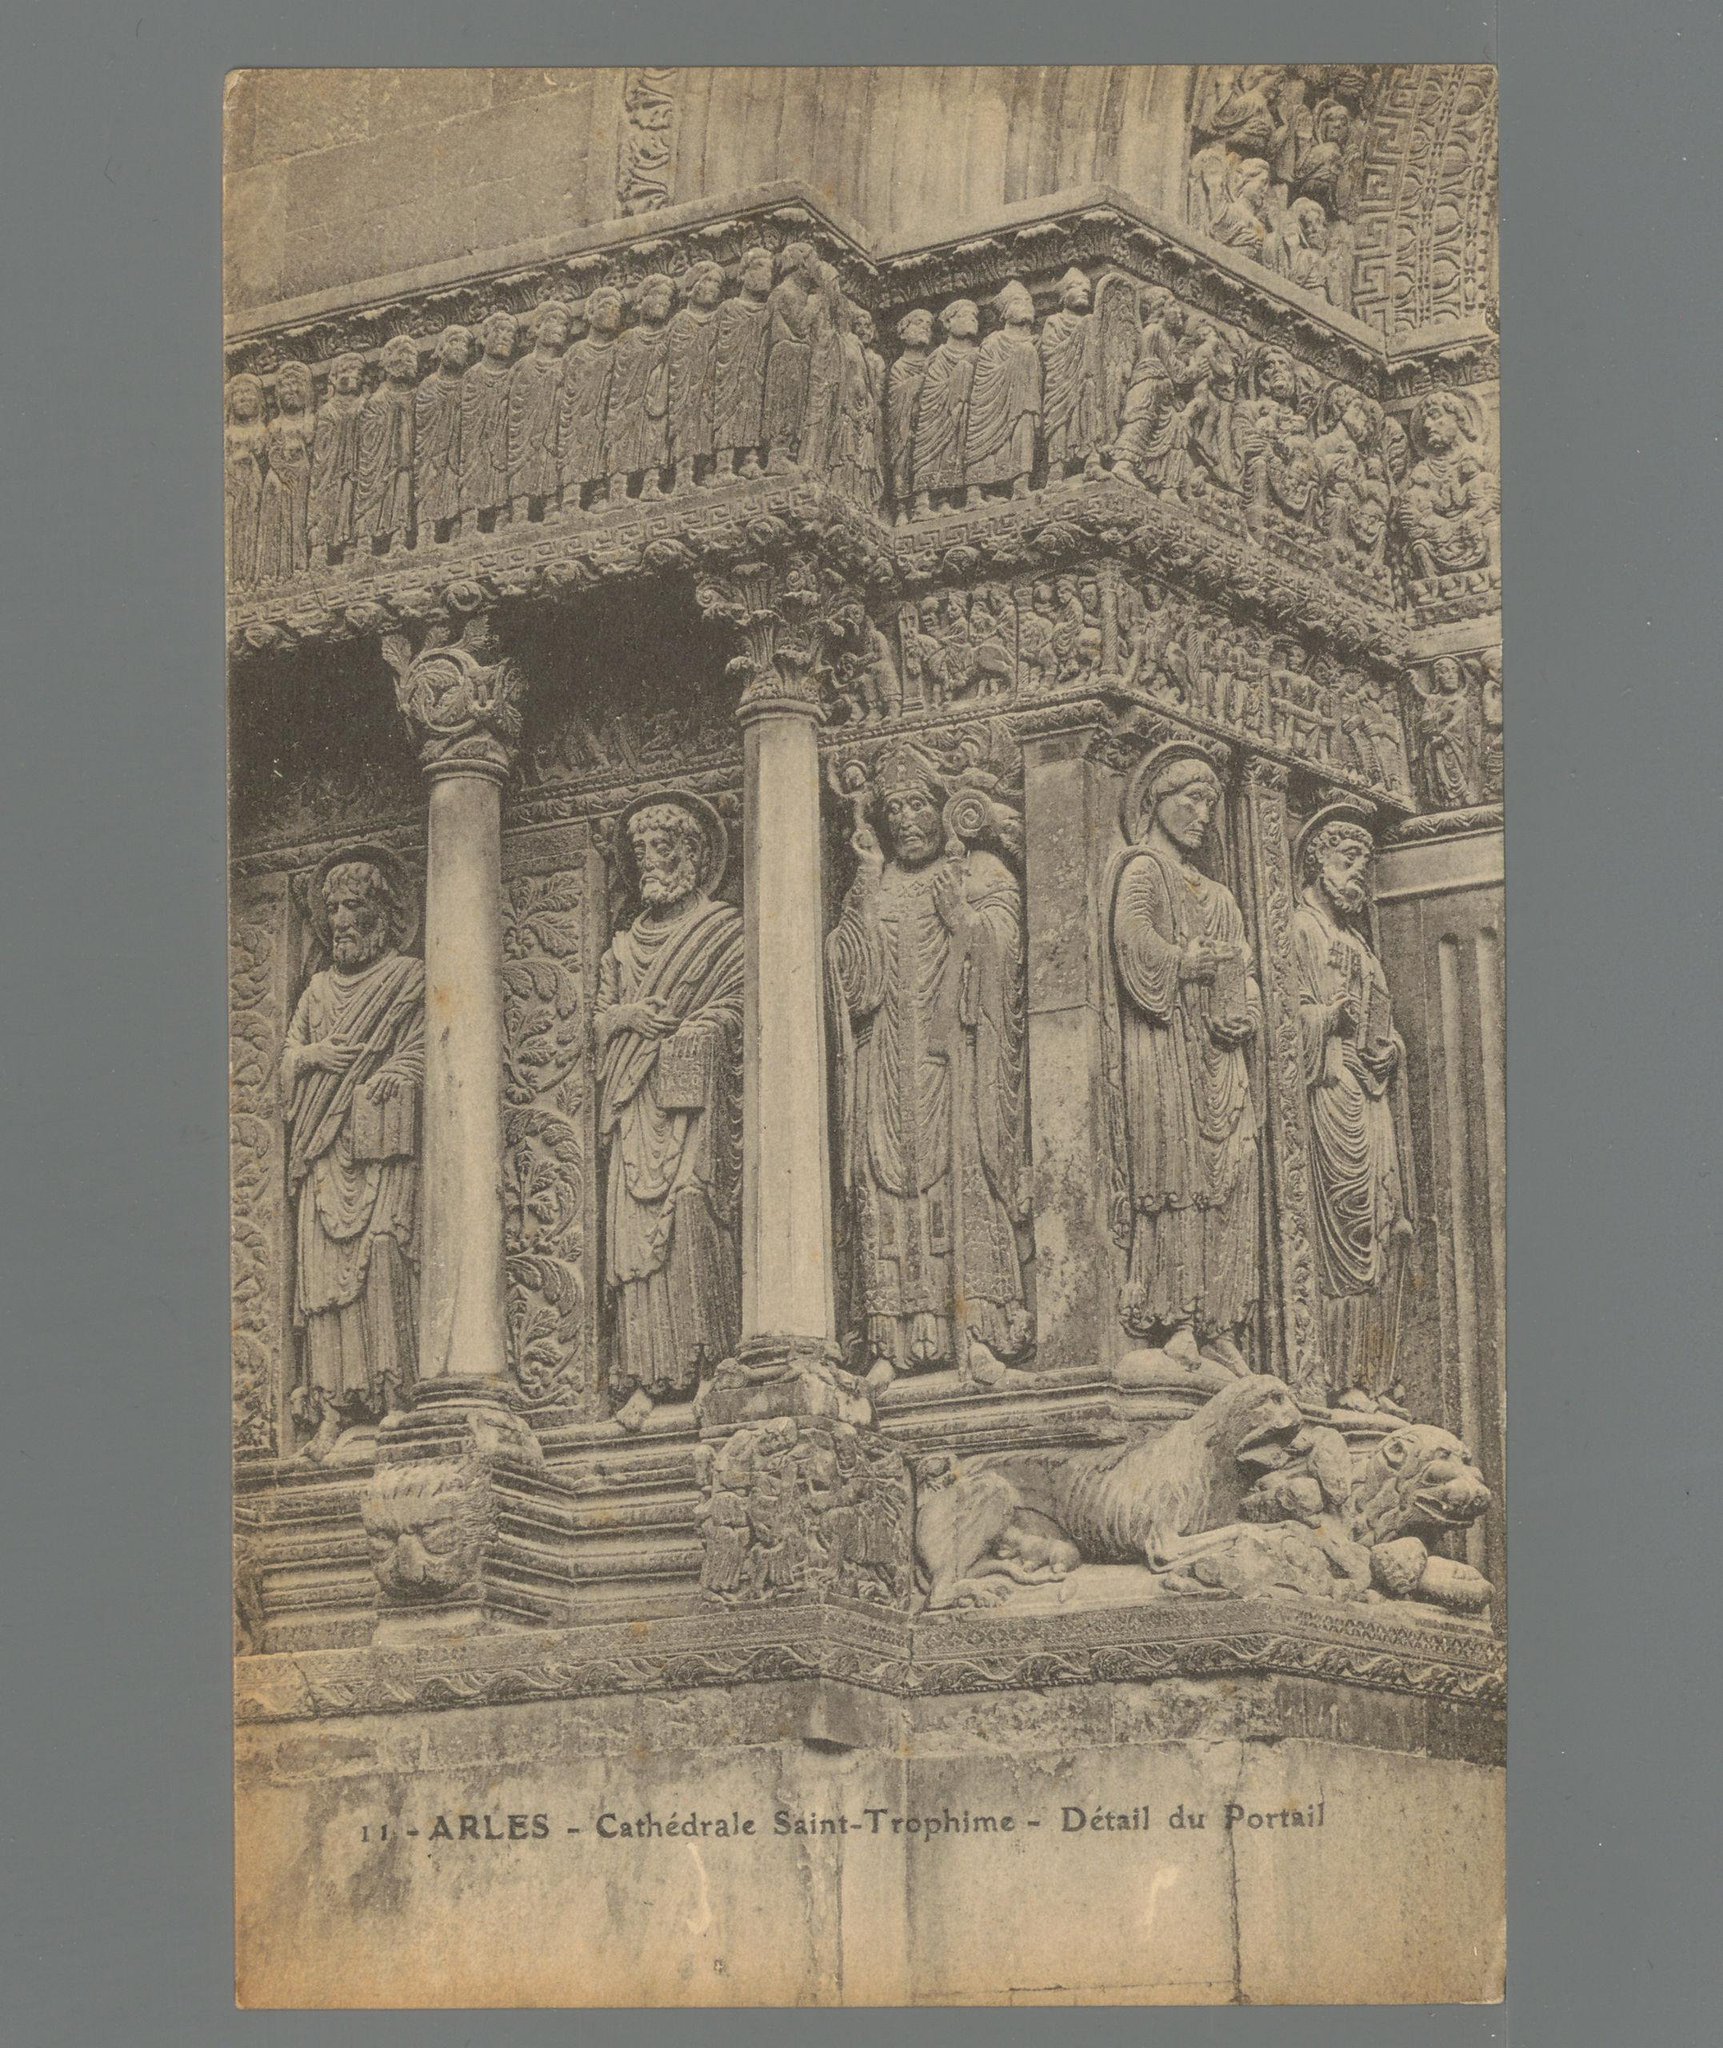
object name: ansichtkaart, prentbriefkaart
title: Arles. Cathédrale Saint-Trophime. Détail du Portail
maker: Anonymous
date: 1903-1930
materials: cardboard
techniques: photograph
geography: arles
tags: parts of church exterior and annexes: portal, sculpture